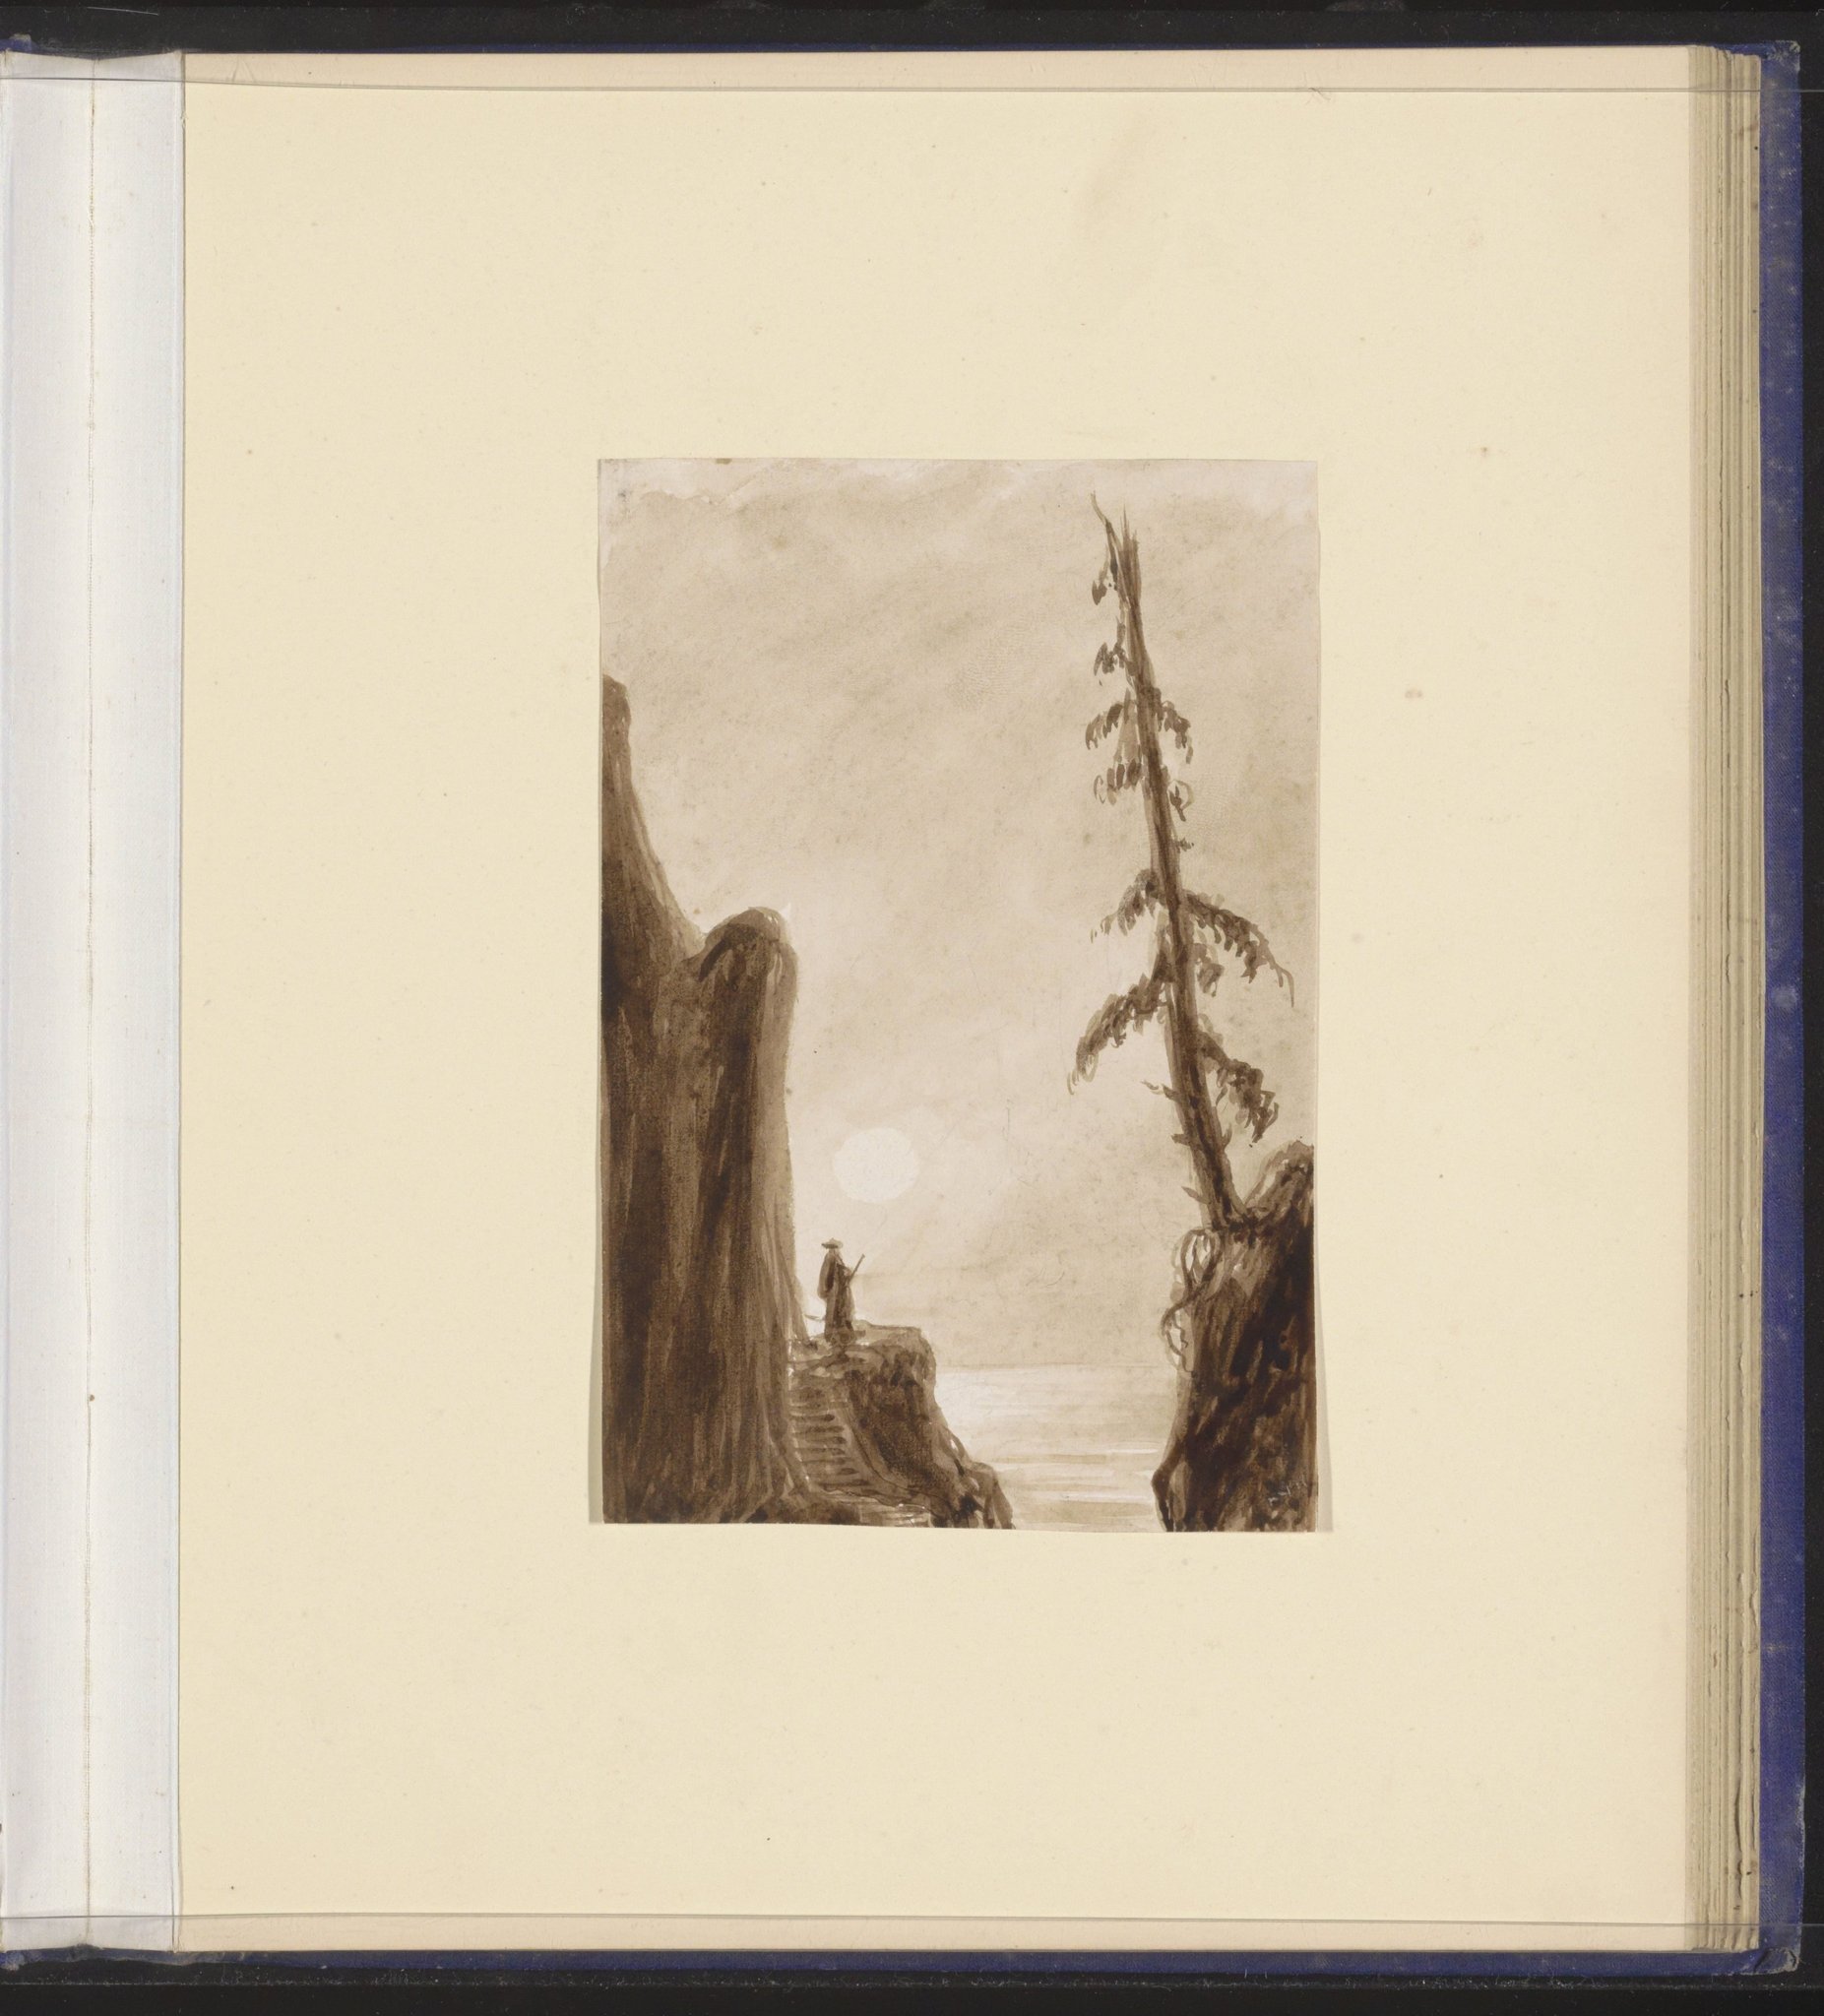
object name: drawing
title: Reiziger op een rots bij het water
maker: alexander ver huell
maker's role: draughtsman, print maker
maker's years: 1822-1897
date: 1882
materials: paper, pencil, watercolor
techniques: brush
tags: landscapes with waters, waterscapes, seascapes (in the temperate zone), 'en route', traveller under way, rocks (+ landscape with figures, staffage)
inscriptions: signature: ‘AVH’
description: De reiziger staat op een uitzichtpunt waar een trap naartoe loopt en kijkt uit over het water. Tekening op blad 8 van een album met 24 ingeplakte schetsen.